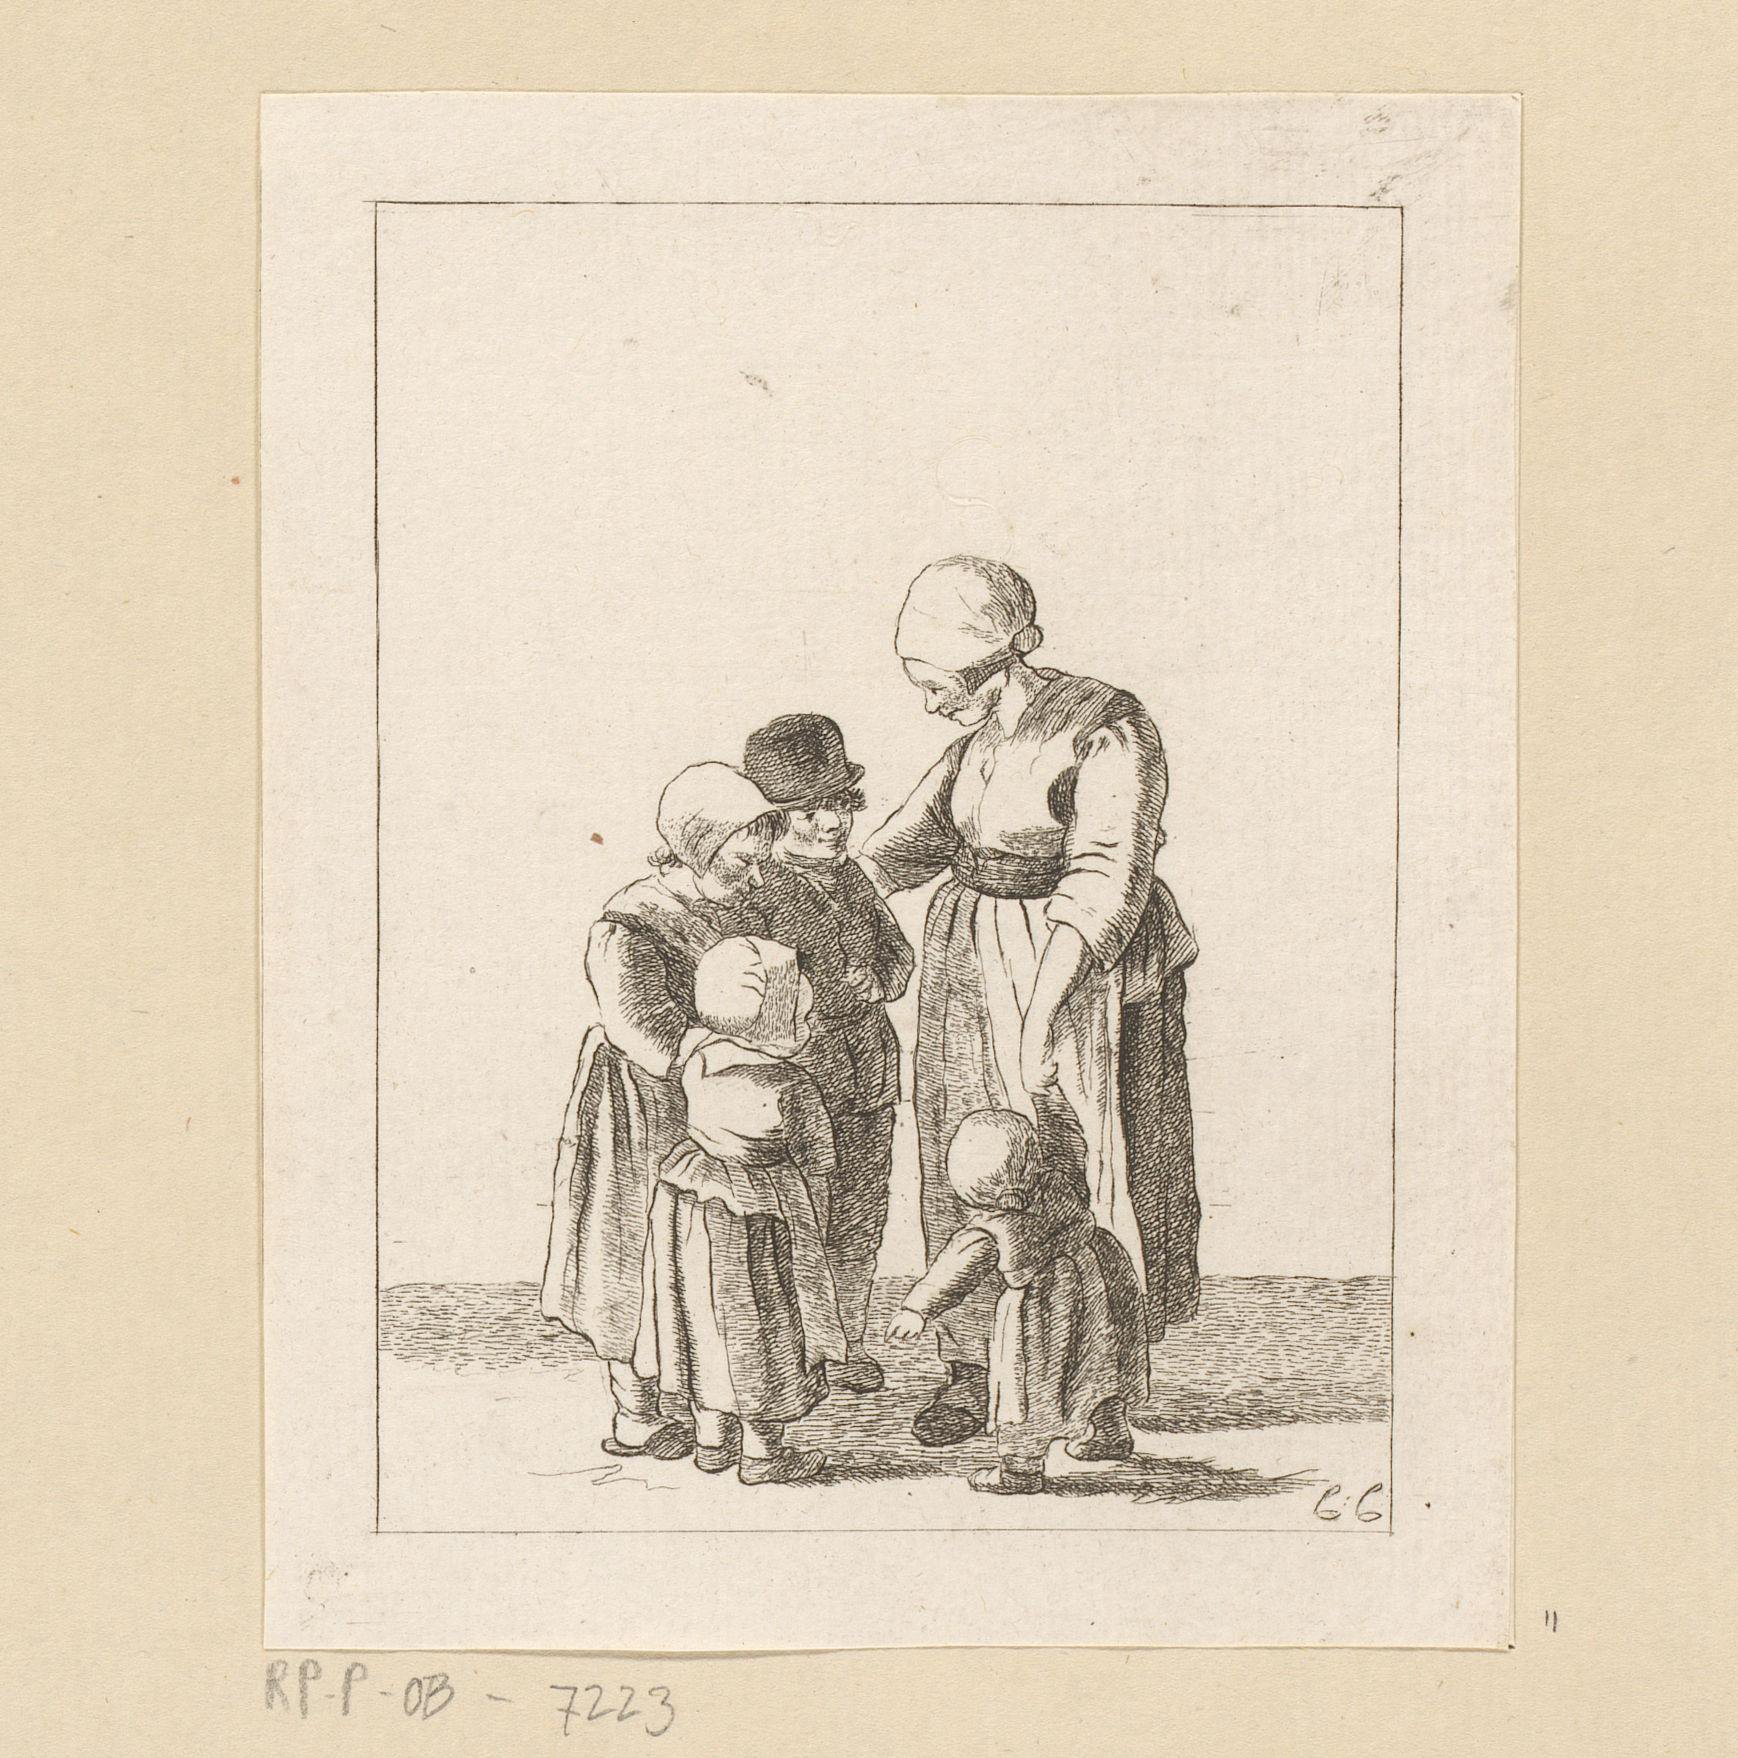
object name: print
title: Moeder met vier kinderen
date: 1779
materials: paper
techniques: etching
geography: leiden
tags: mother and baby or young child, brothers or sisters (second degree family relationships)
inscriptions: collector's mark: Lugt 2228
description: Een moeder met vier kinderen. De jongste houdt ze bij de hand.